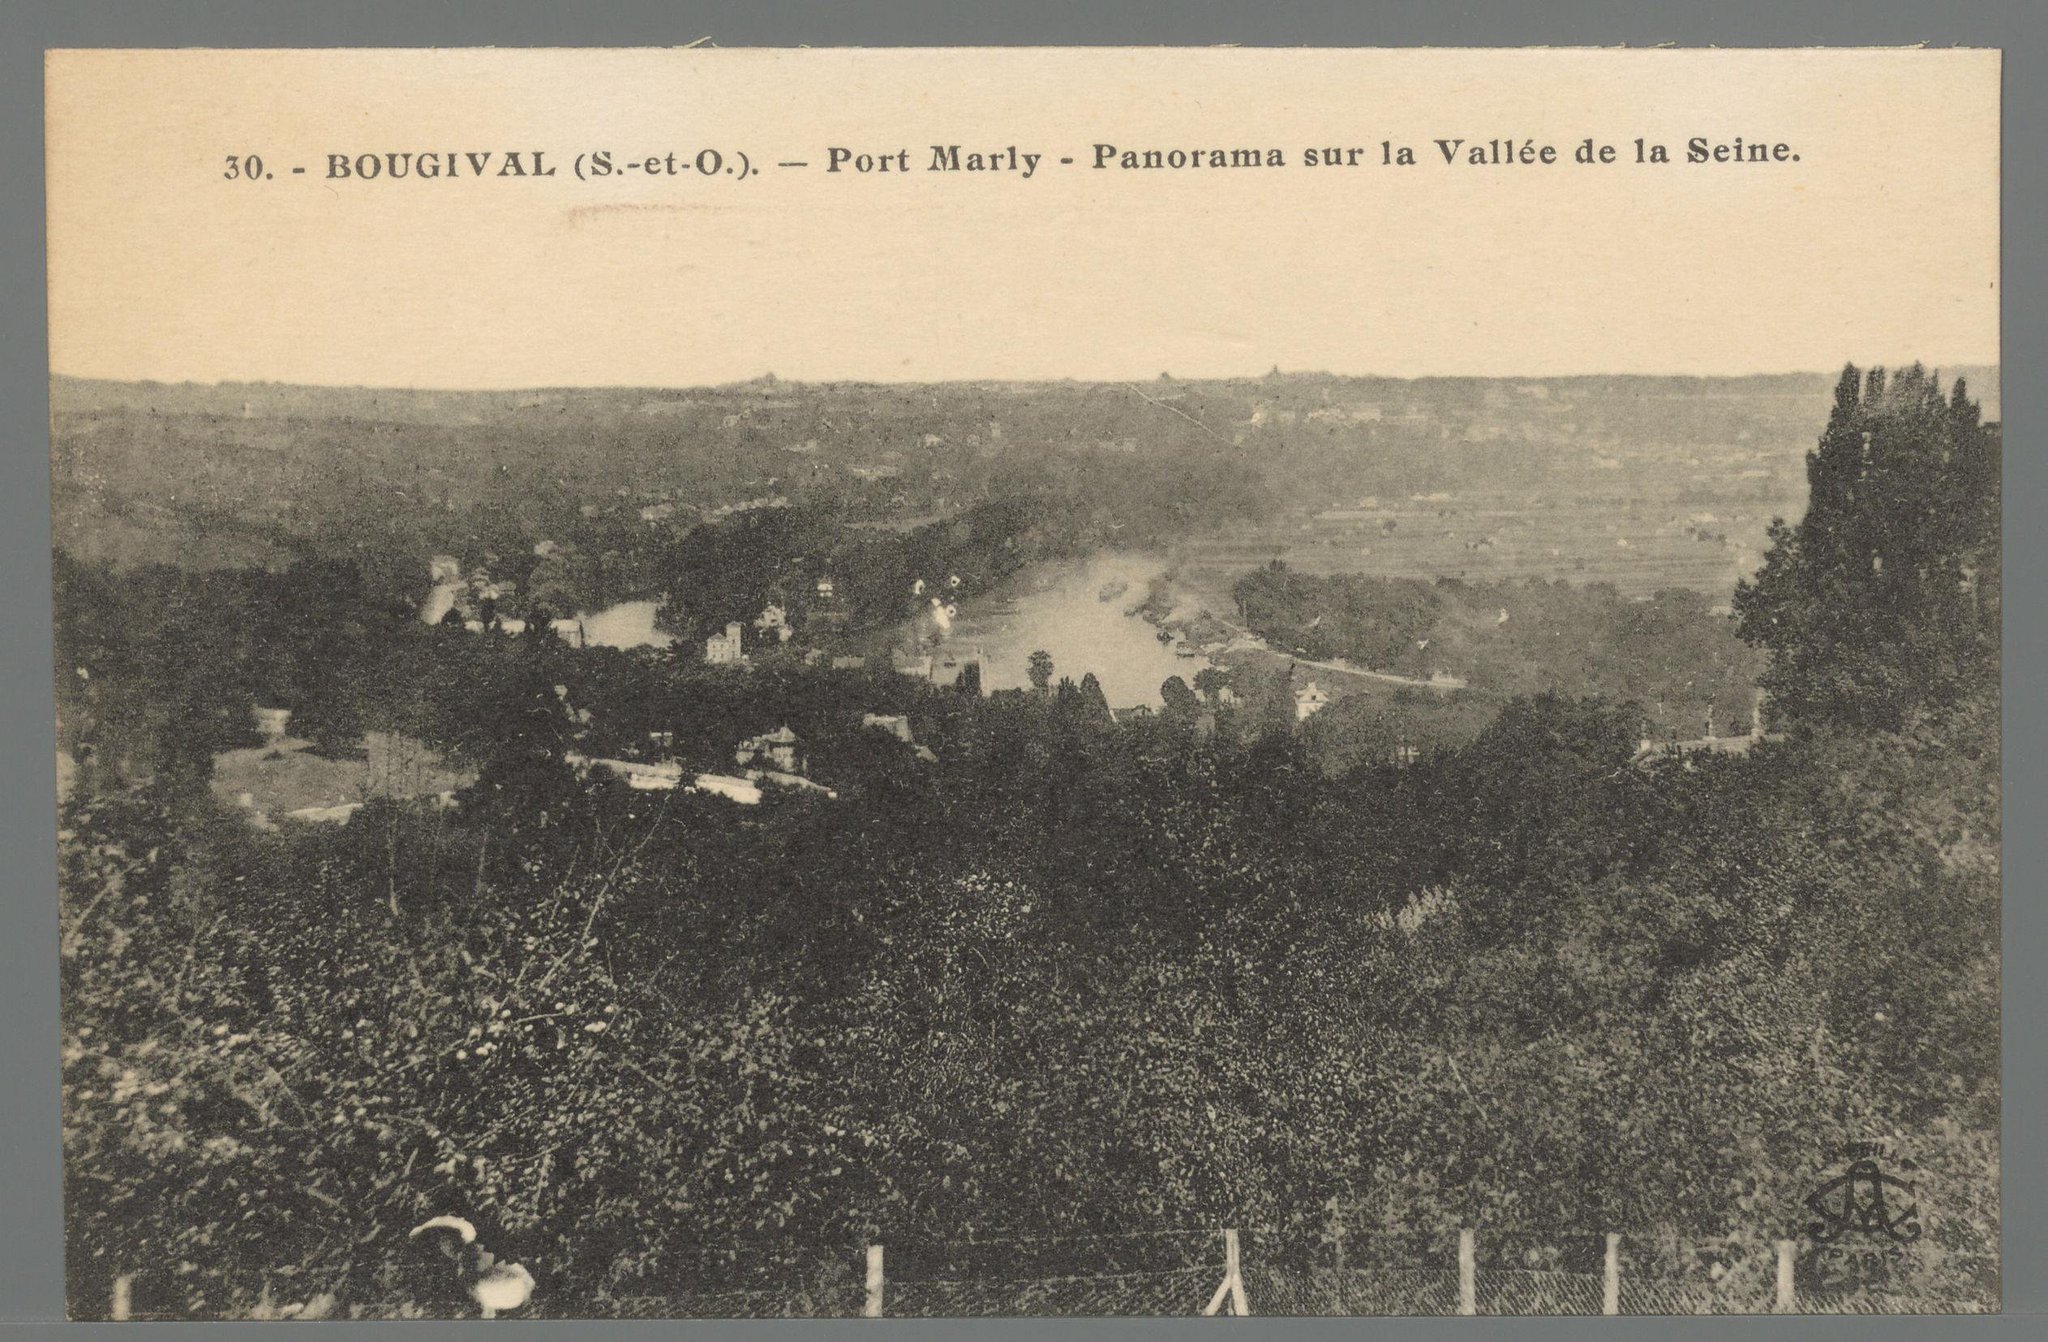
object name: ansichtkaart, prentbriefkaart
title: Bougival (S.-et-O.) - Port Marly - Panorama sur la Vallée de la Seine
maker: Anonymous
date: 1916-1930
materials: cardboard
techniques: photograph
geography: bougival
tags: harbour, river, prospect of city, town panorama, silhouette of city